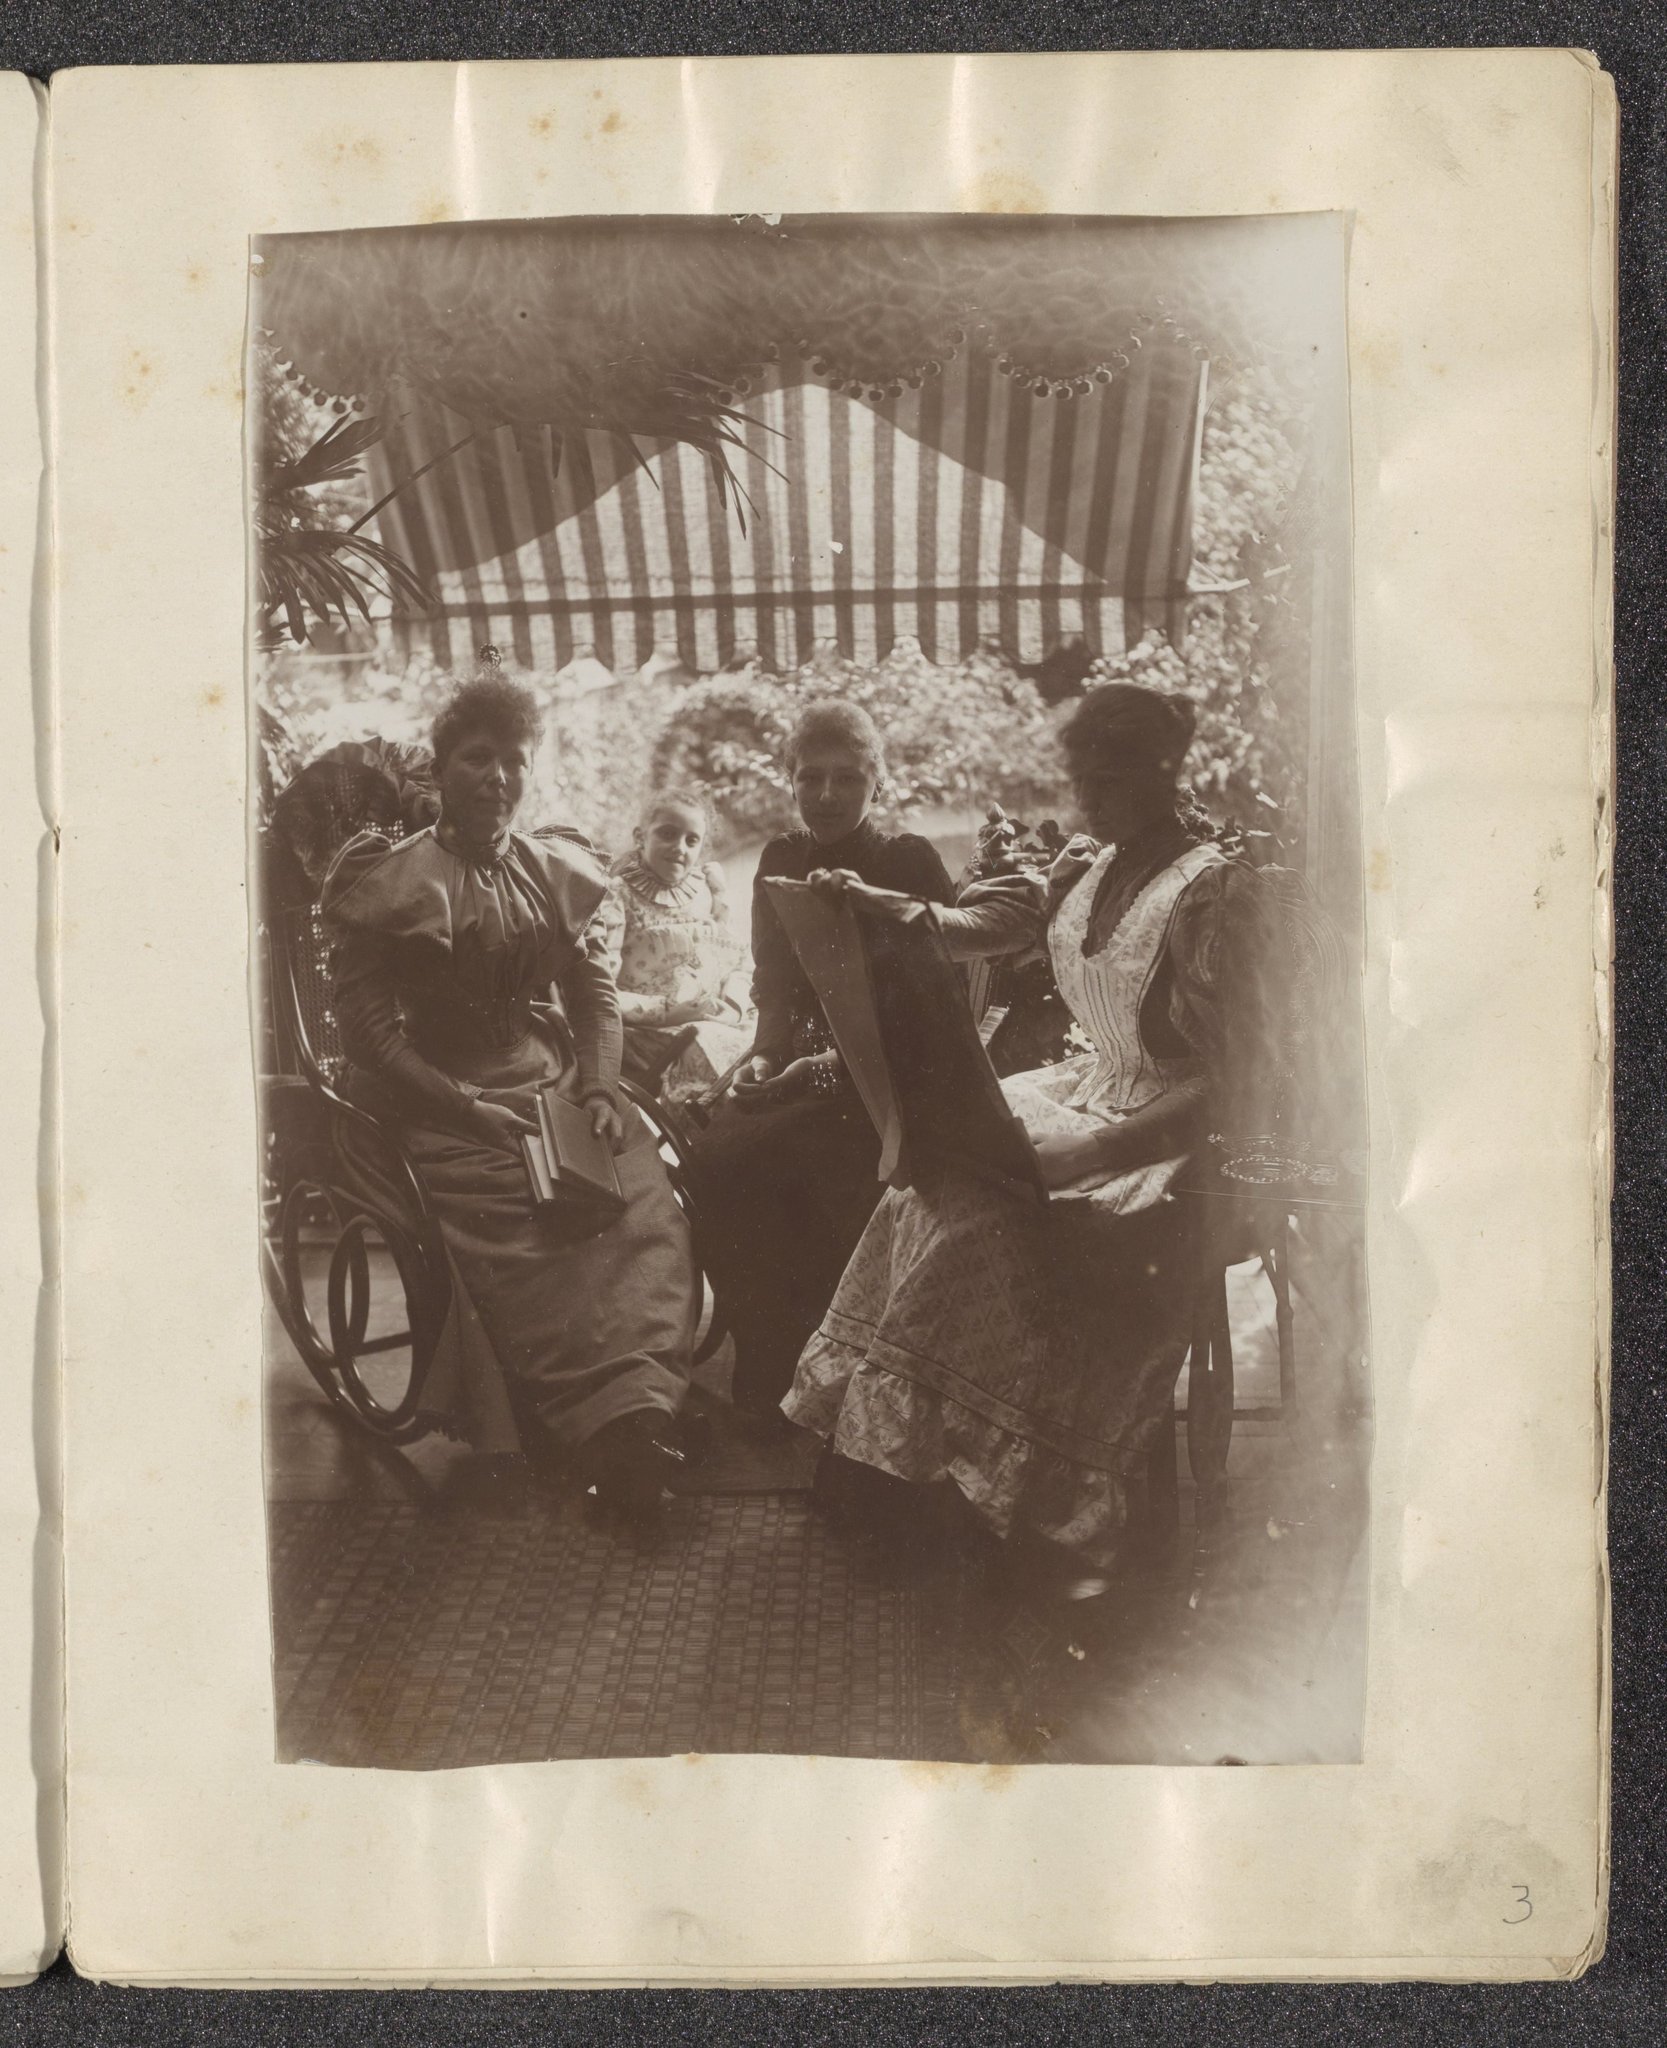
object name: photograph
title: Drie vrouwen en een meisje zittend onder een overkapping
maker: Anonymous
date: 1900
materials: paper, photographic support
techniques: collodion silver print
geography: france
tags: adult woman, canopy, baldachin, rocking-chair (+ wood and other phytogenic material), child, historical persons, styles of hairdress - aa - ~ women, family, relationship, descent, book, loggia, verandah, porch, apron (+ women's clothes), france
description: Onderdeel van Album met 8 foto's van (vermoedelijk) een Franse familie.